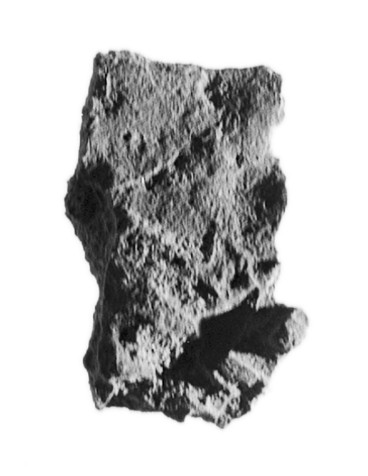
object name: sealing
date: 1981-1640 BCE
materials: mud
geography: egypt